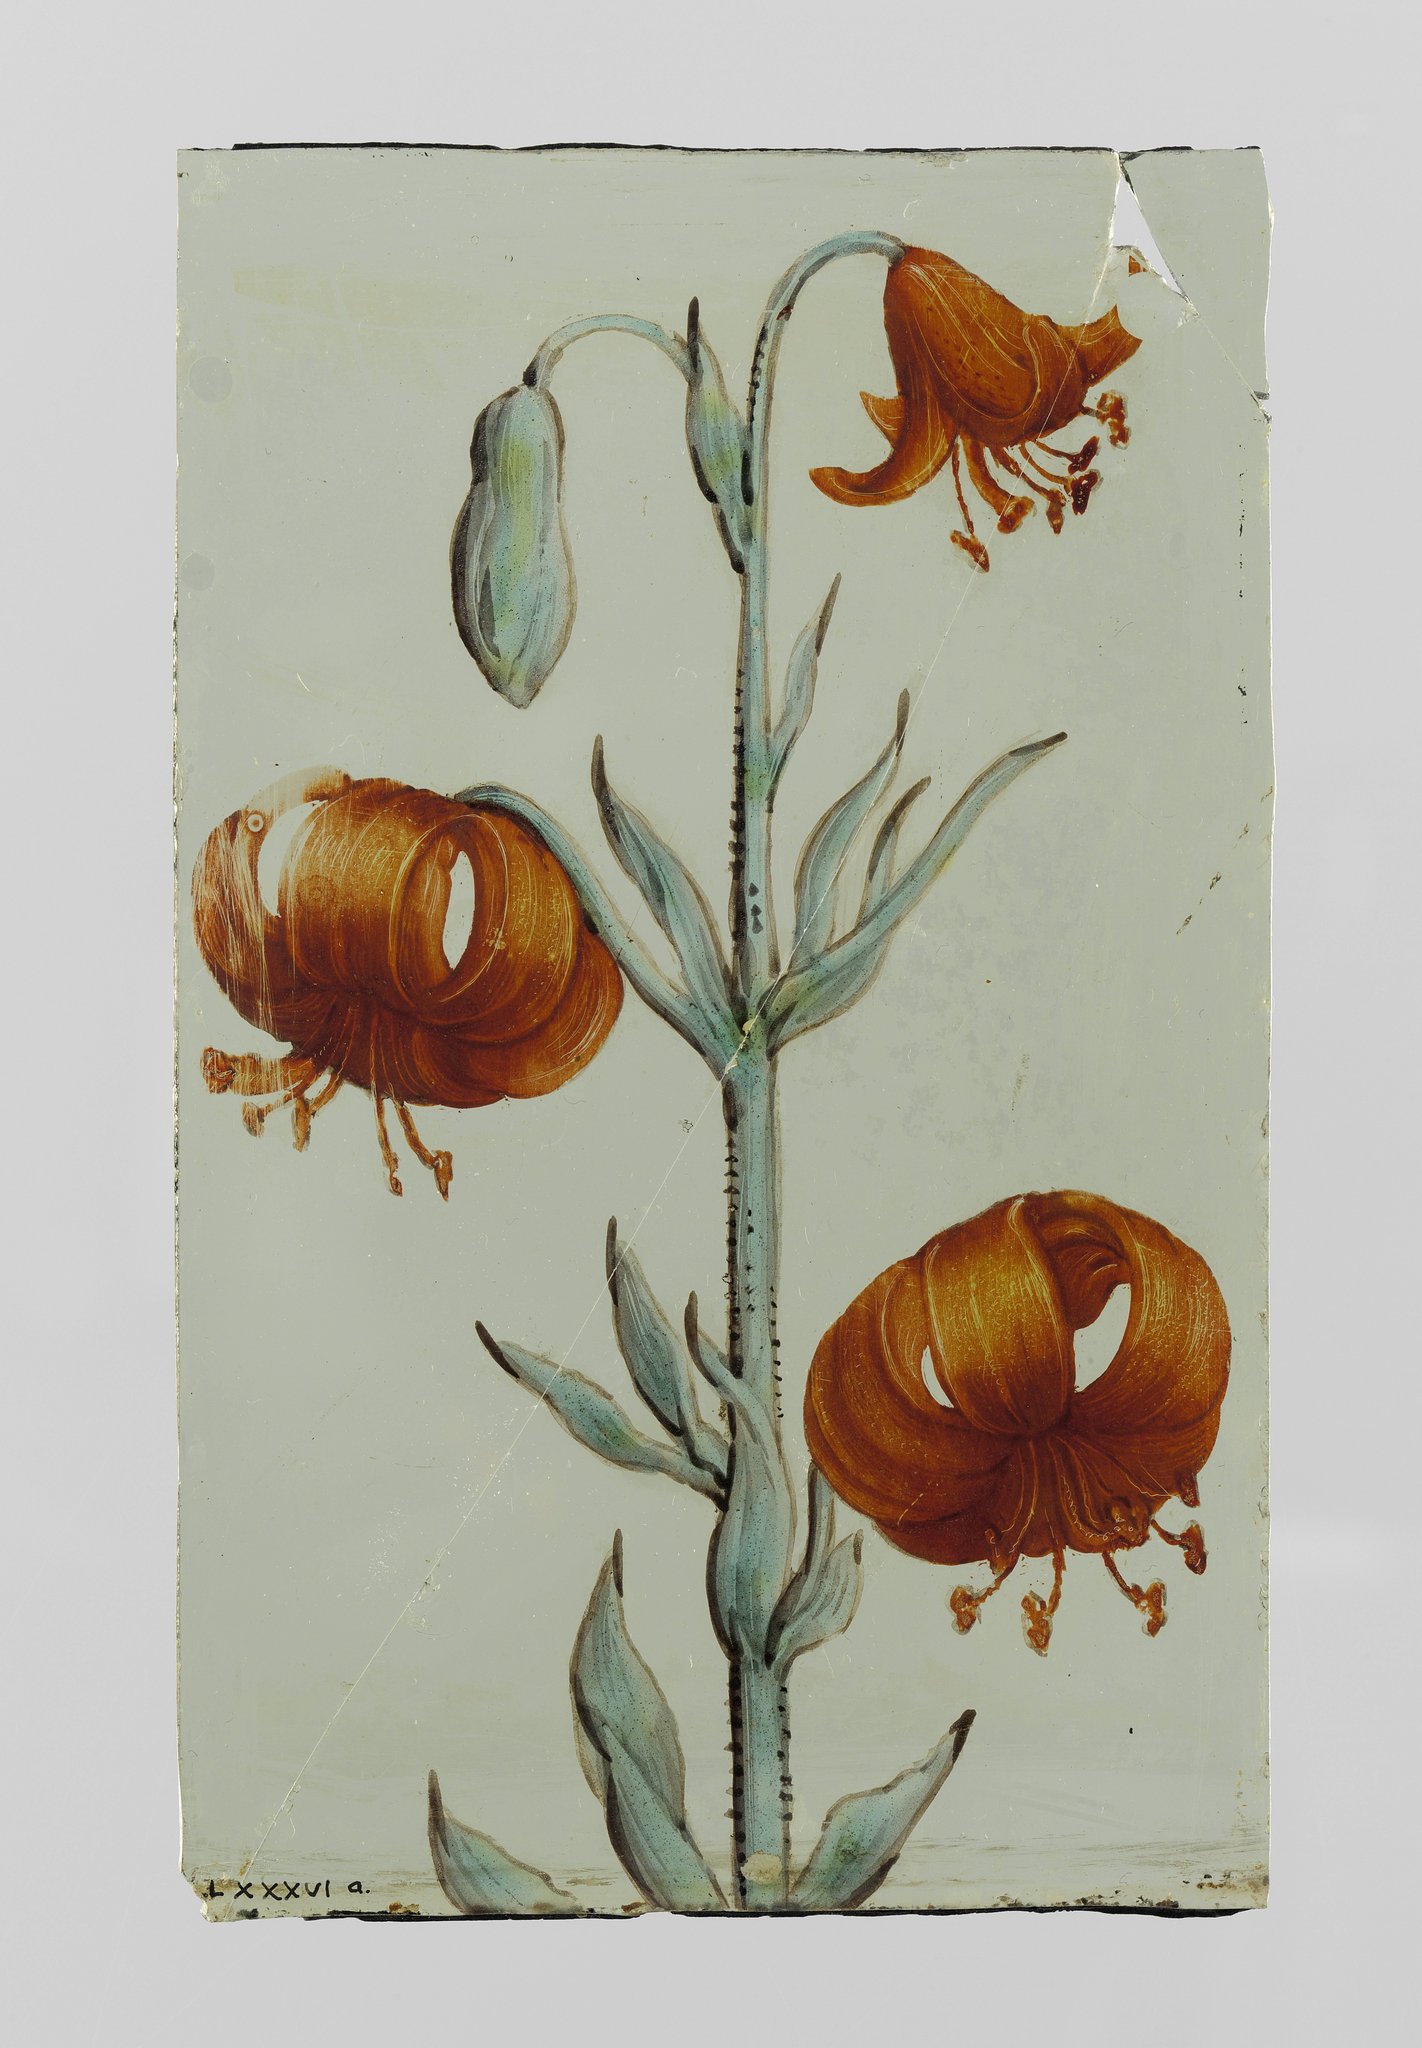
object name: light window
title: Ruit met een lelie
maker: Anonymous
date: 1650-1675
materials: glass, lead, pigment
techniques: enamel painting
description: Een ruit met emailschildering van een lelie in voornamelijk blauw en oranjerood.